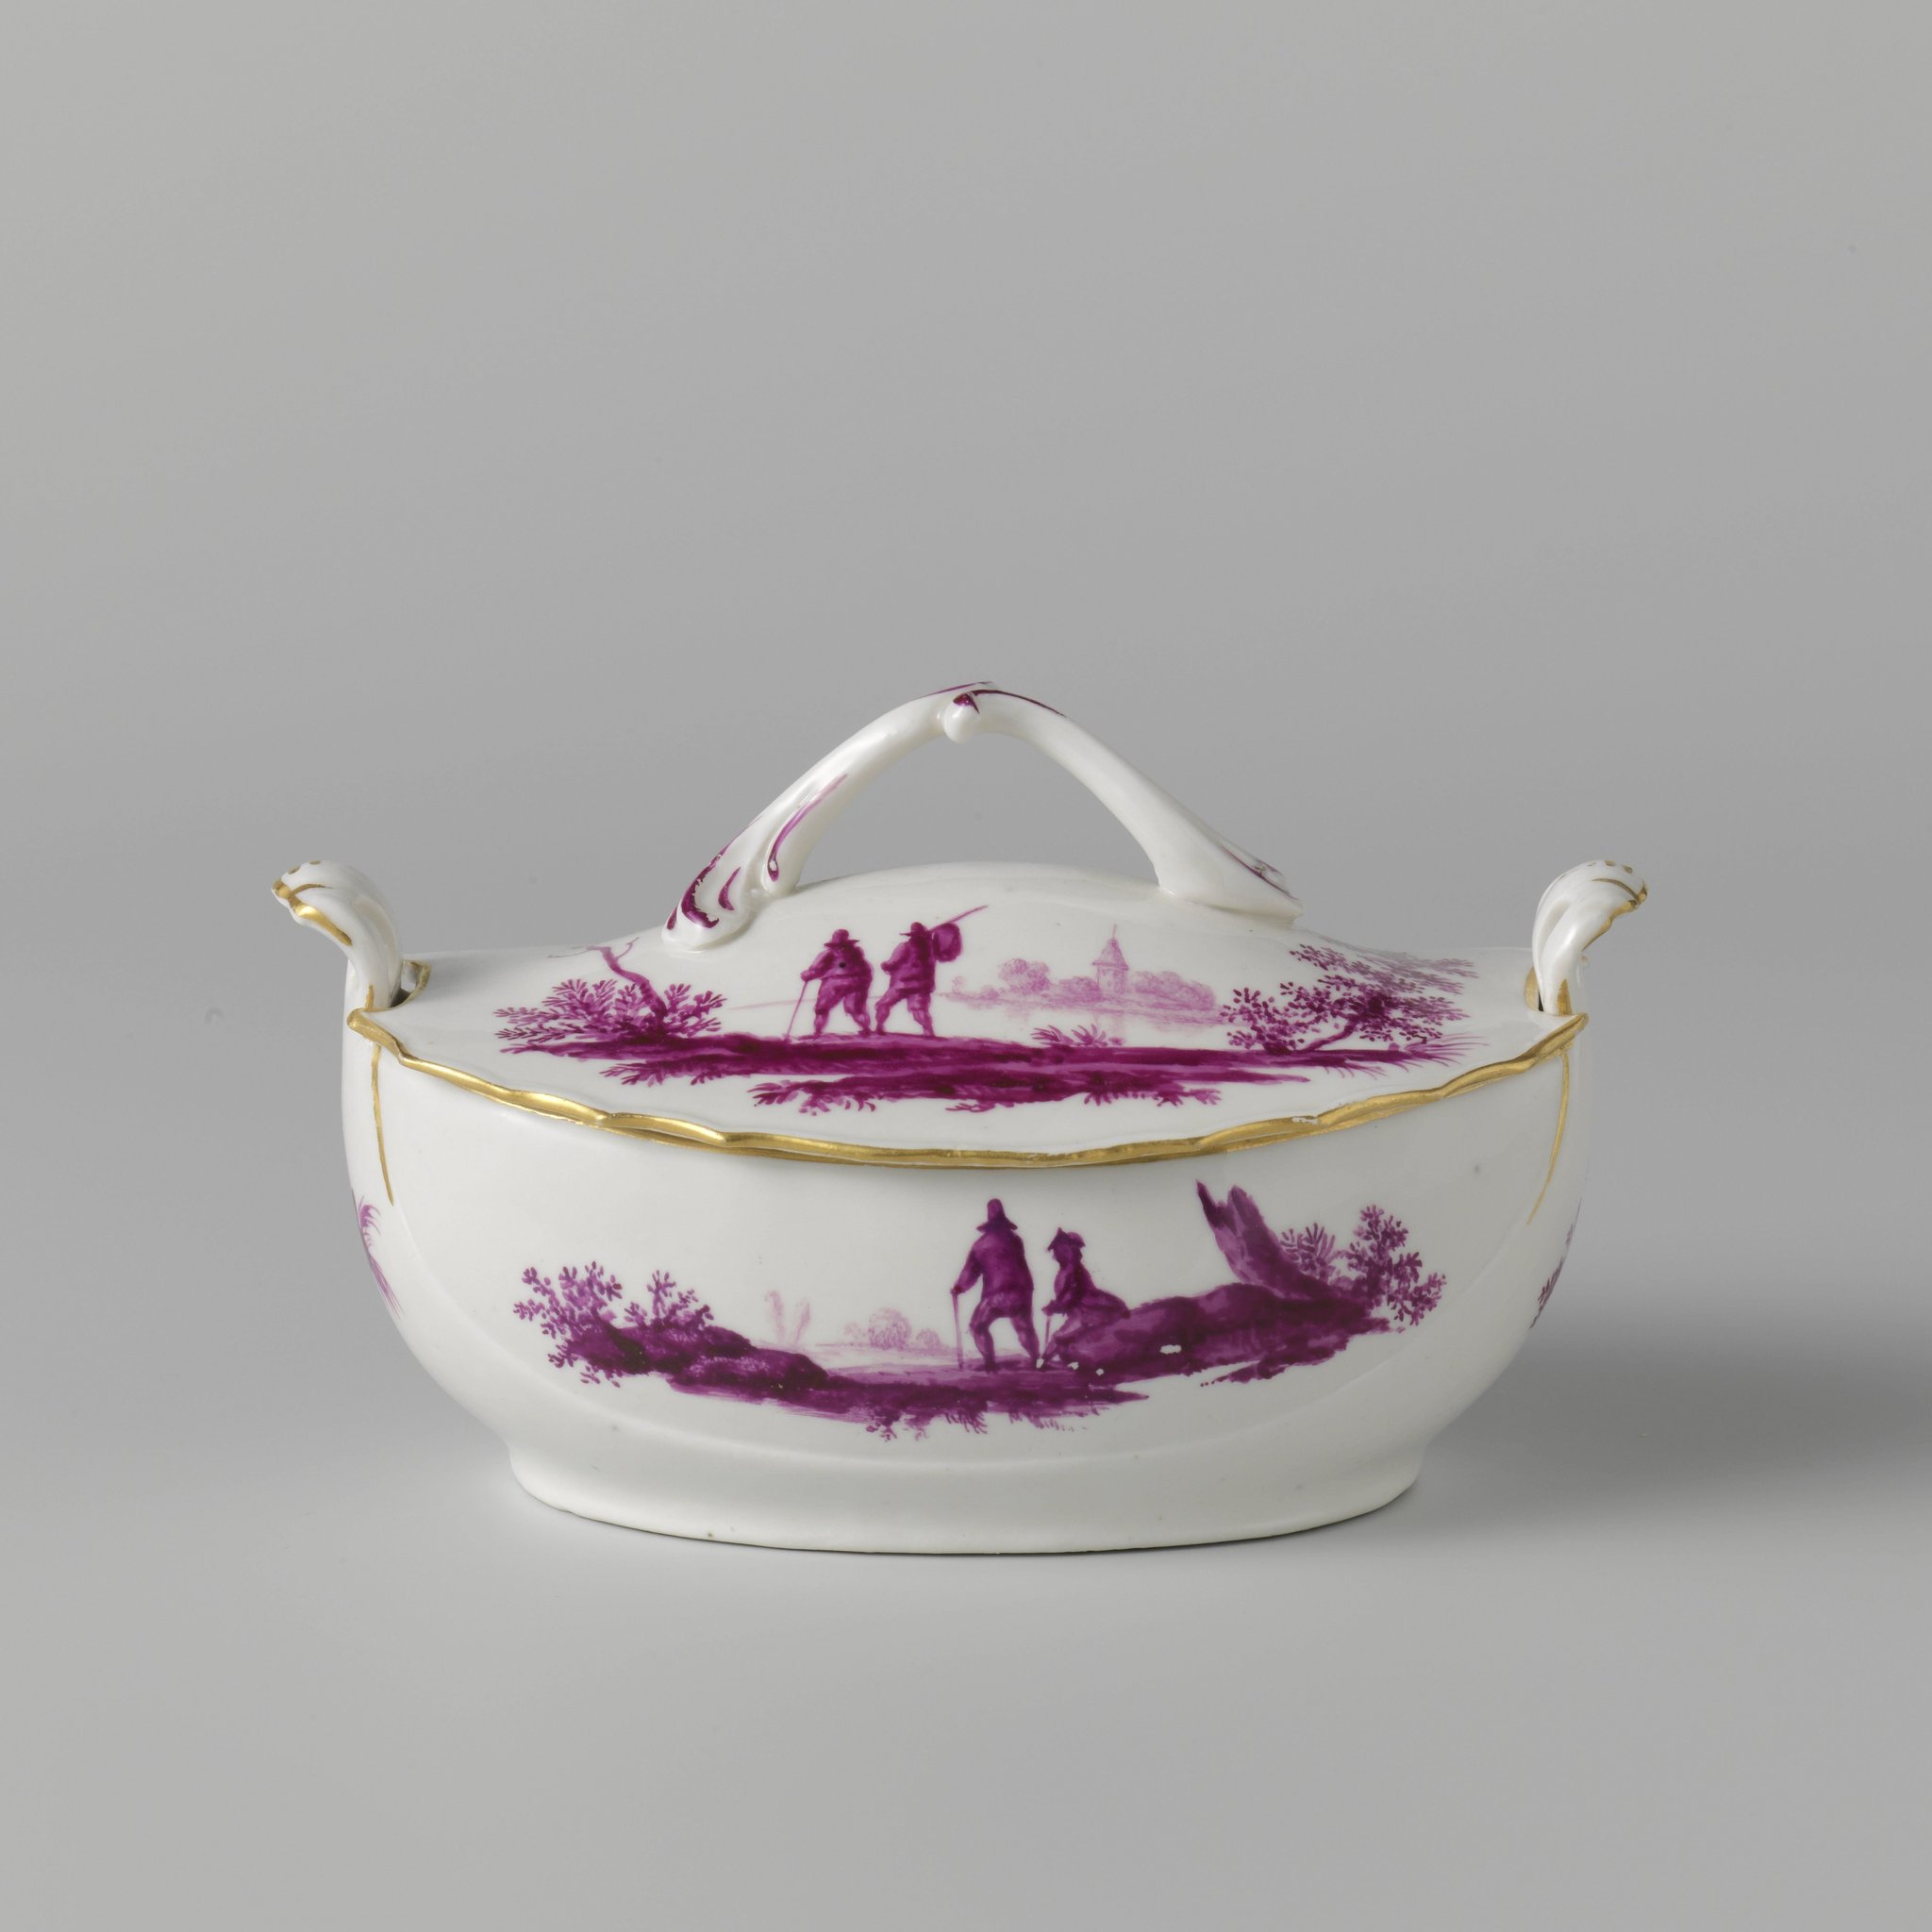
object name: lid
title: Deksel, veelkleurig beschilderd met figuren in een rivierlandschap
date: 1774-1778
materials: porcelain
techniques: kiln, painted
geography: loosdrecht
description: Deksel van porselein. Deksel en schotelrand geschulpt. Beschilderd in bietenrood met figuren in een rivierlandschap. Gouden biezen langs dekselrand. Handvat beschilderd met ornament in bietenrood.